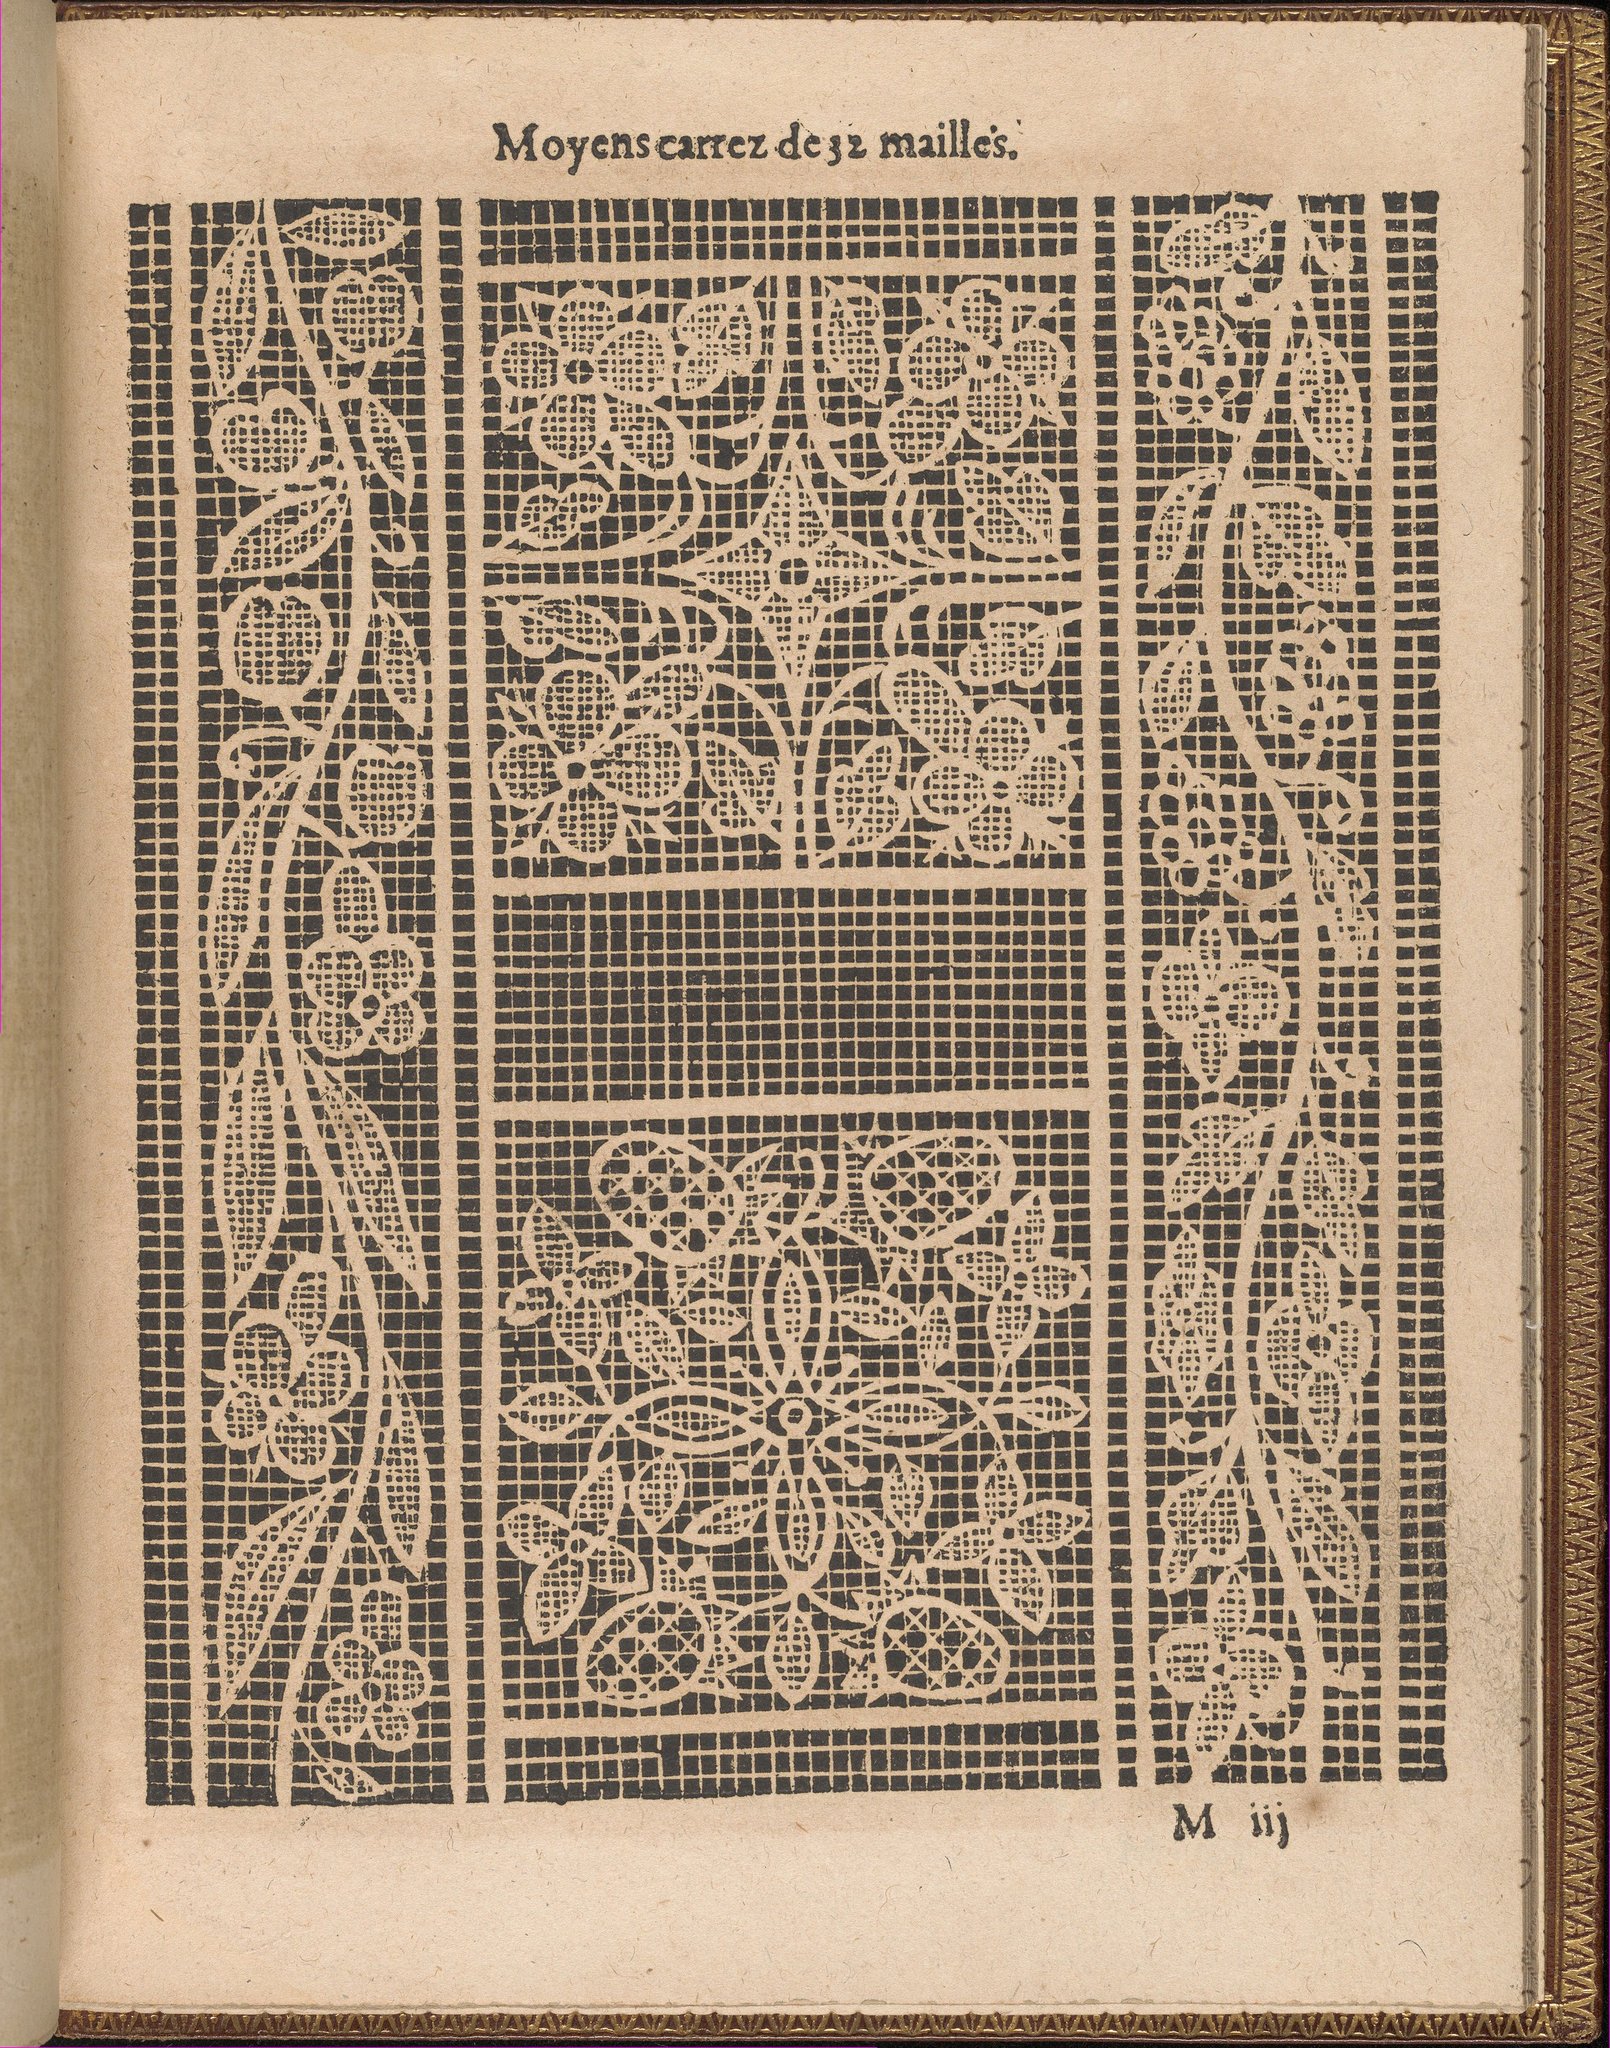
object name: book print ornament architecture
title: La Pratique de l'Aiguille, page 46 (recto)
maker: matthias mignerak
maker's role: author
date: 1605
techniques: woodcut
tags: flowers